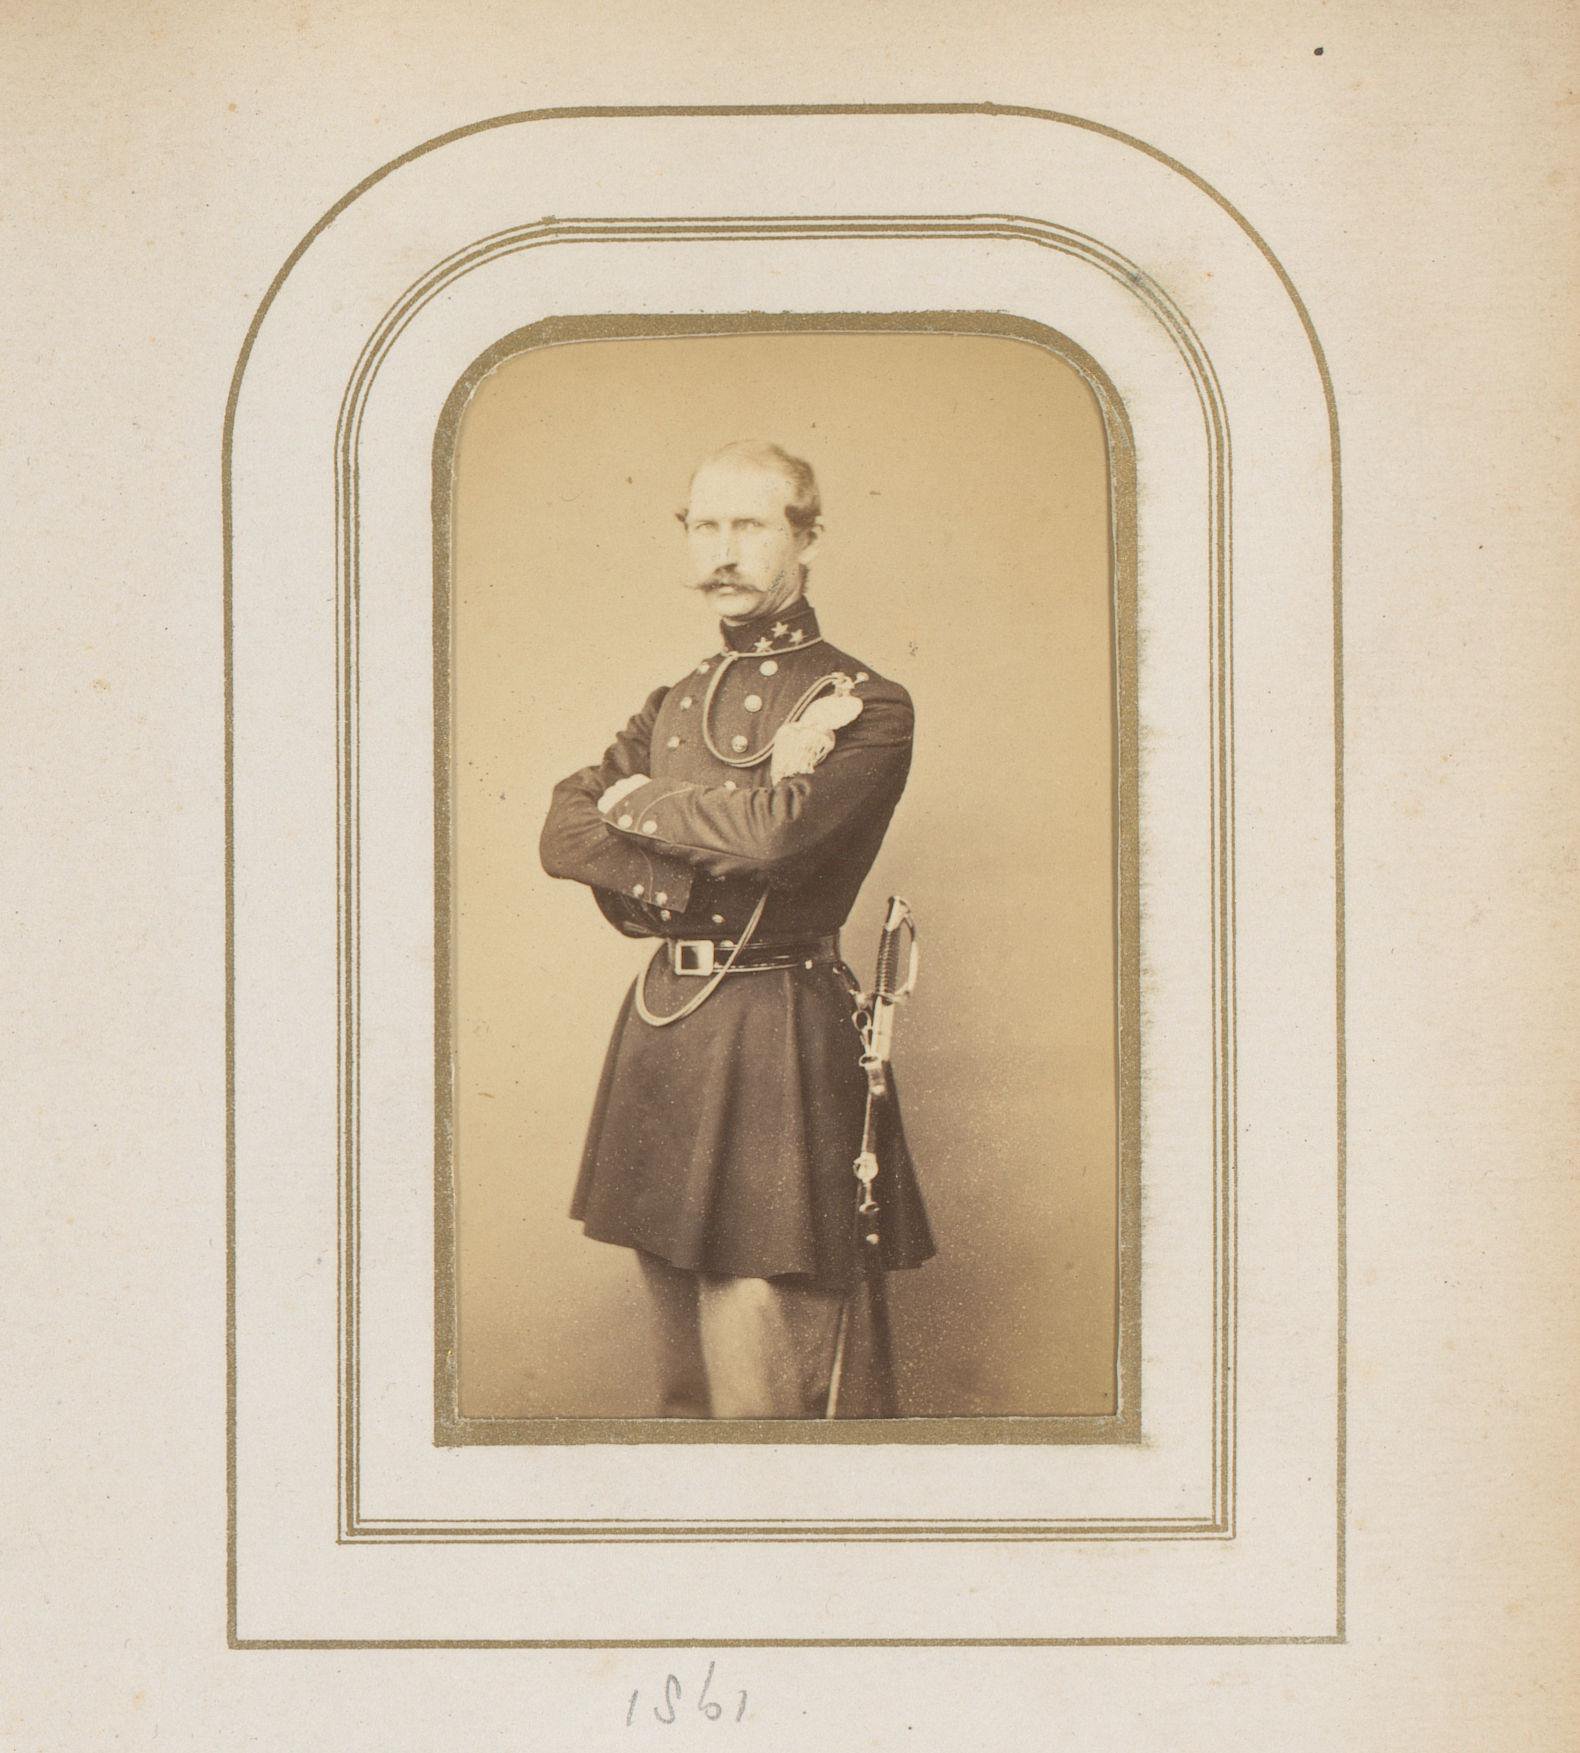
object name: photograph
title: Portret van een man met zwaard in uniform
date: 1861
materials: cardboard, photographic support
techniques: albumen print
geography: brussels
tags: historical persons, hacking and thrusting weapons: sword, (military) uniforms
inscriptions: date: ‘1861’, inscription: ‘Photographie Allemande/ Ch. Billotte et Cie/ Place de la Monnaie 9 Rue de la Reine/ Bruxelles’, annotation: ‘souvenir de bonne amitié/ 10 Juin 1861/ [Baudraal]’